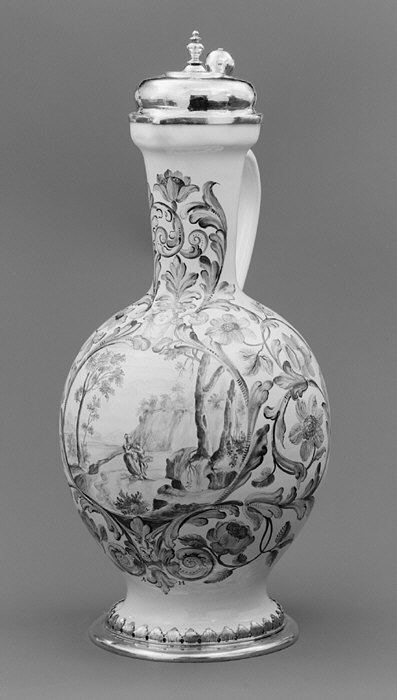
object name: flagon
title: Flagon (one of a pair)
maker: abraham helmhack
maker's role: decorator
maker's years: 1654-1724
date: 1690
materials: earthenware, silver gilt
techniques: glazing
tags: human figures,flowers